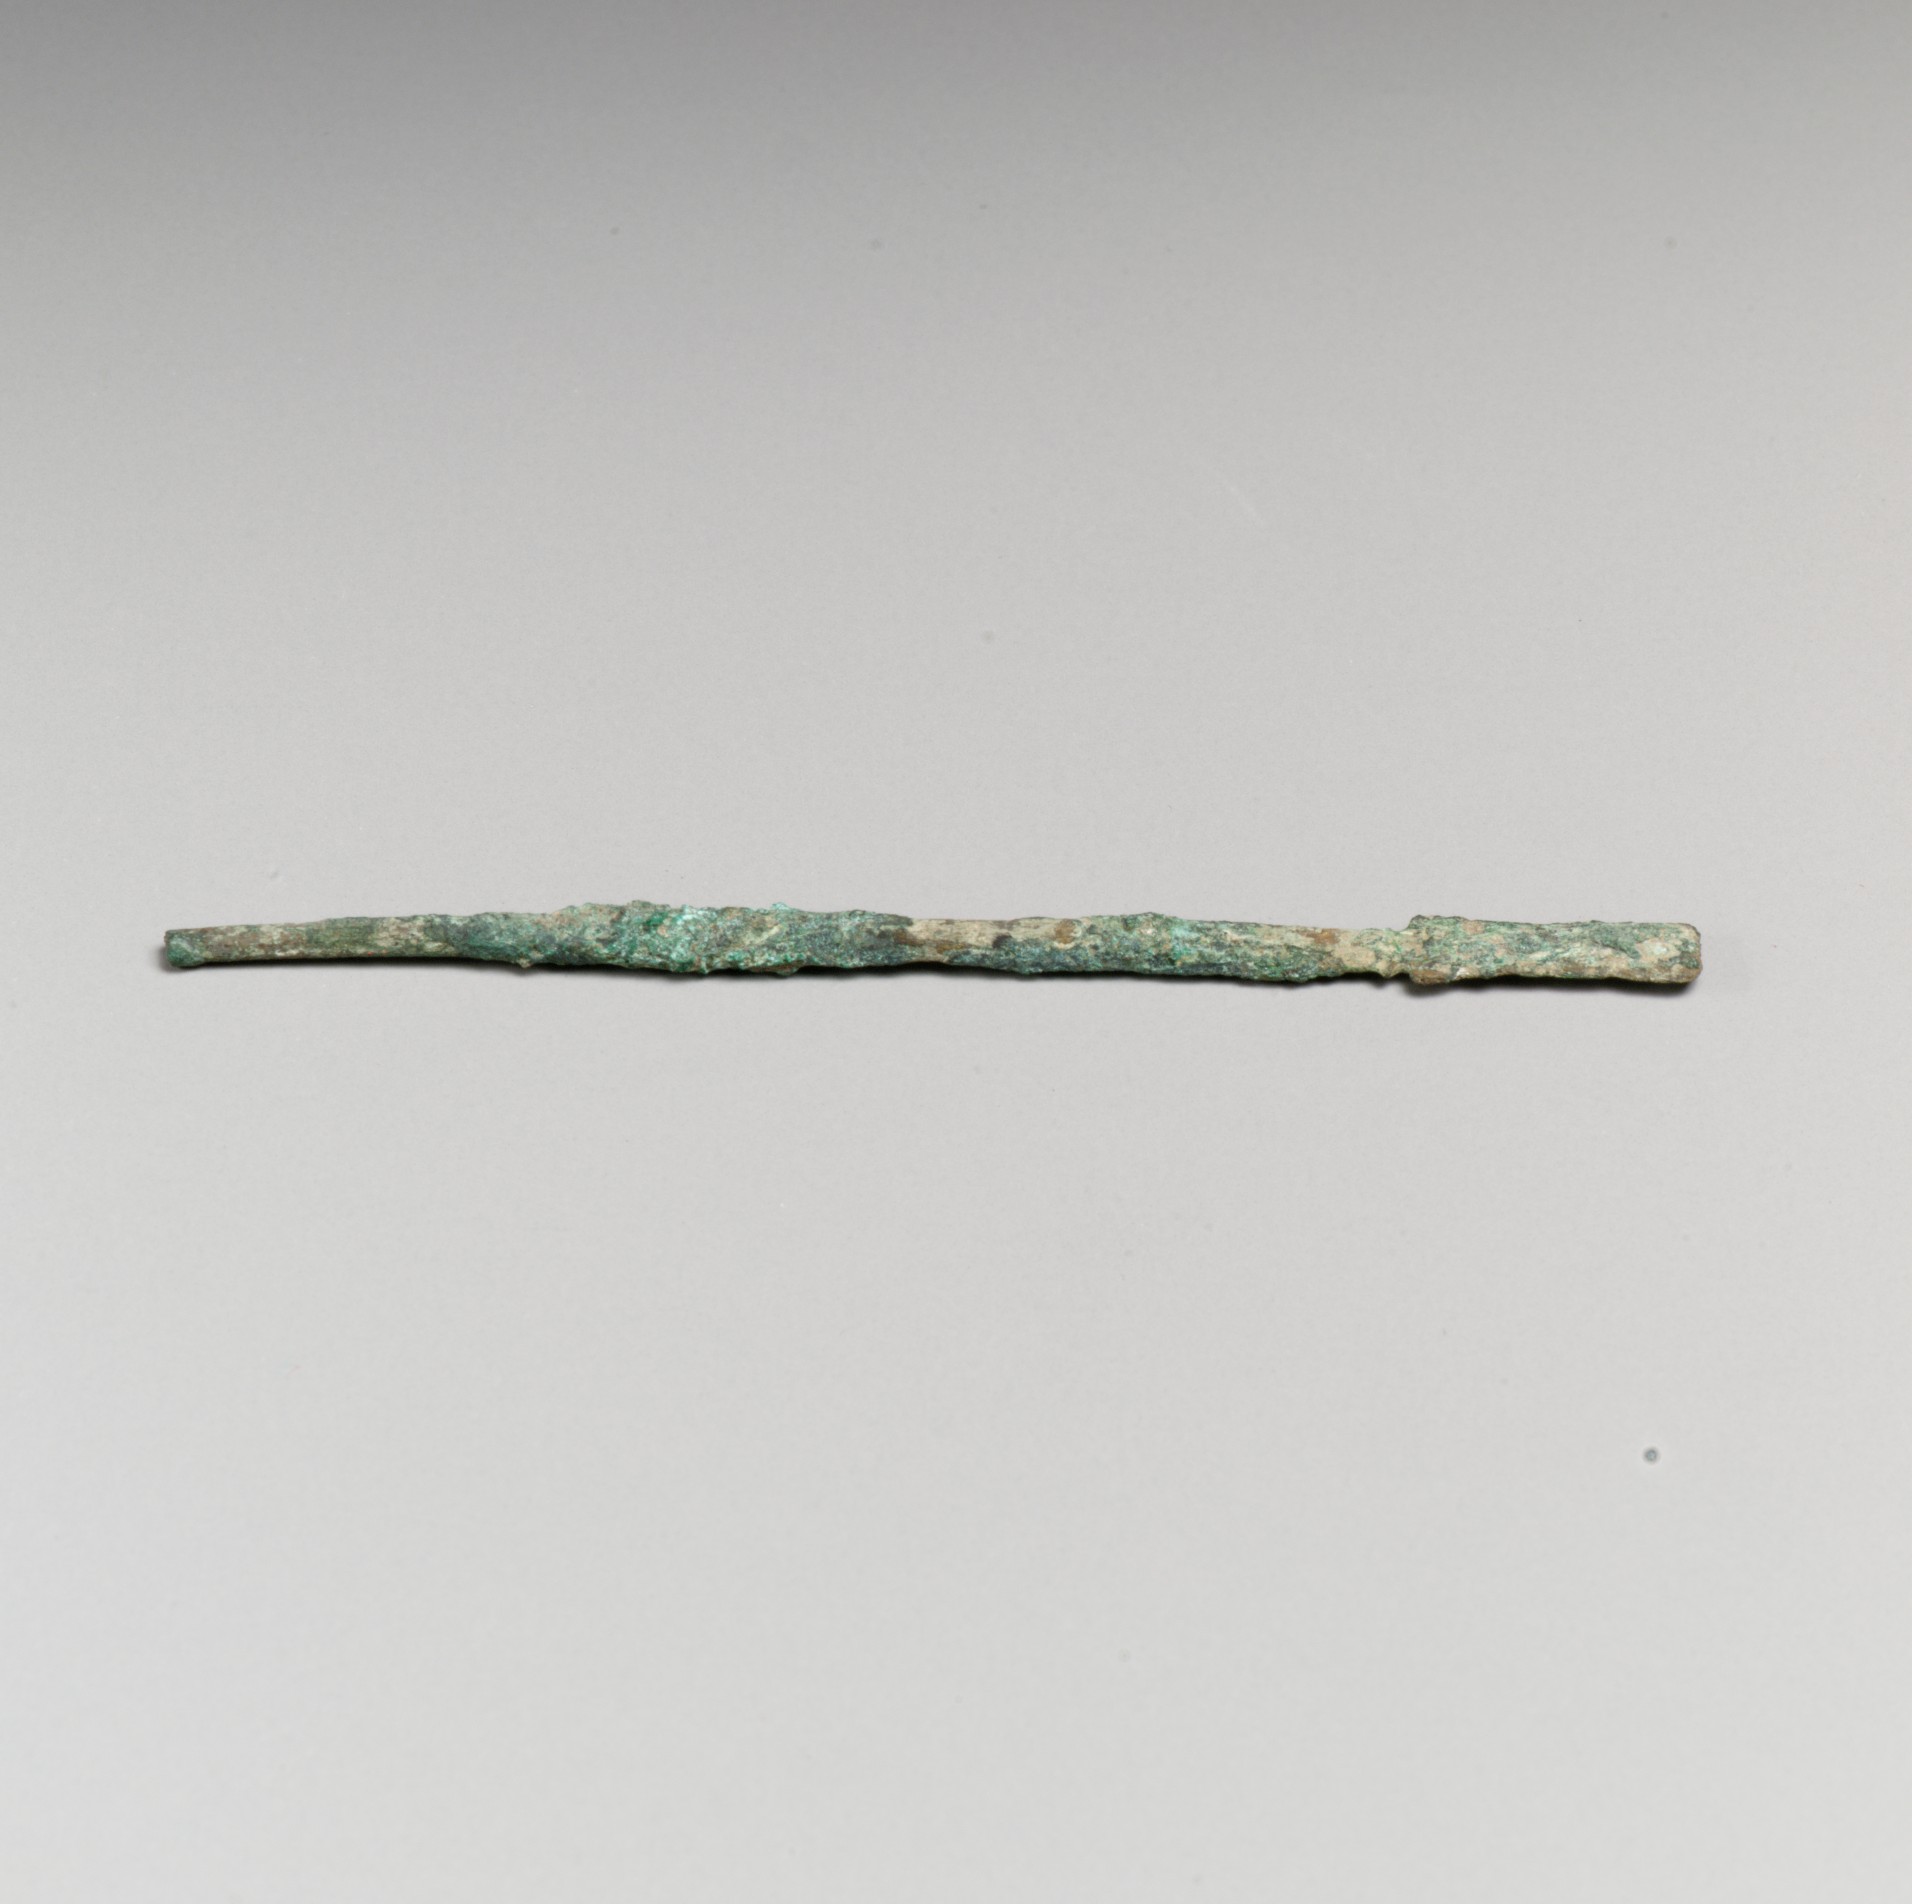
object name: chisel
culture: roman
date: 670 BCE-330 CE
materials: bone, bronze